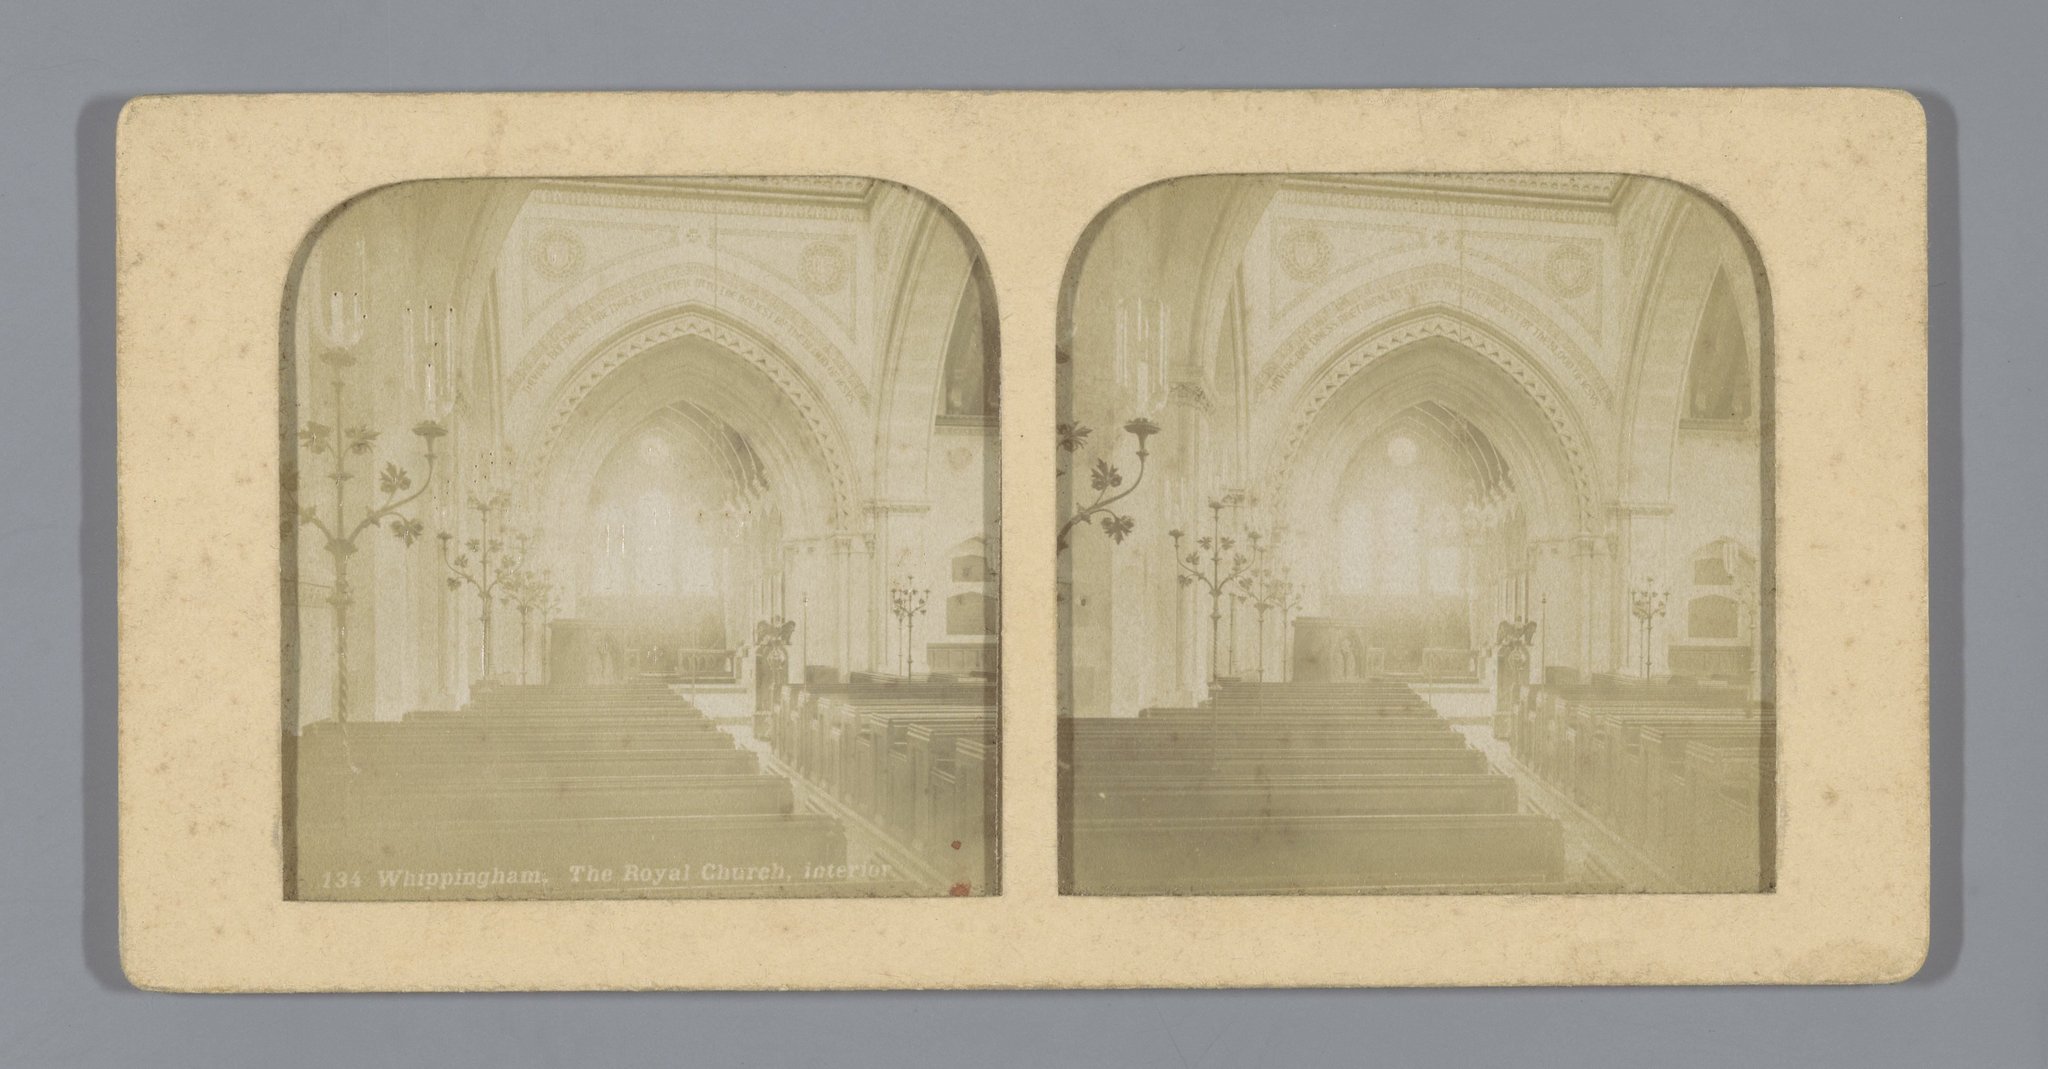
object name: tissue stereograph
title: Whippingham. The Royal Church, interior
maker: Anonymous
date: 1855-1875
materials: cardboard, paper, photographic support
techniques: albumen print, hand coloring, perforating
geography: whippingham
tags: parts of church interior: nave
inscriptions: number: ‘134’